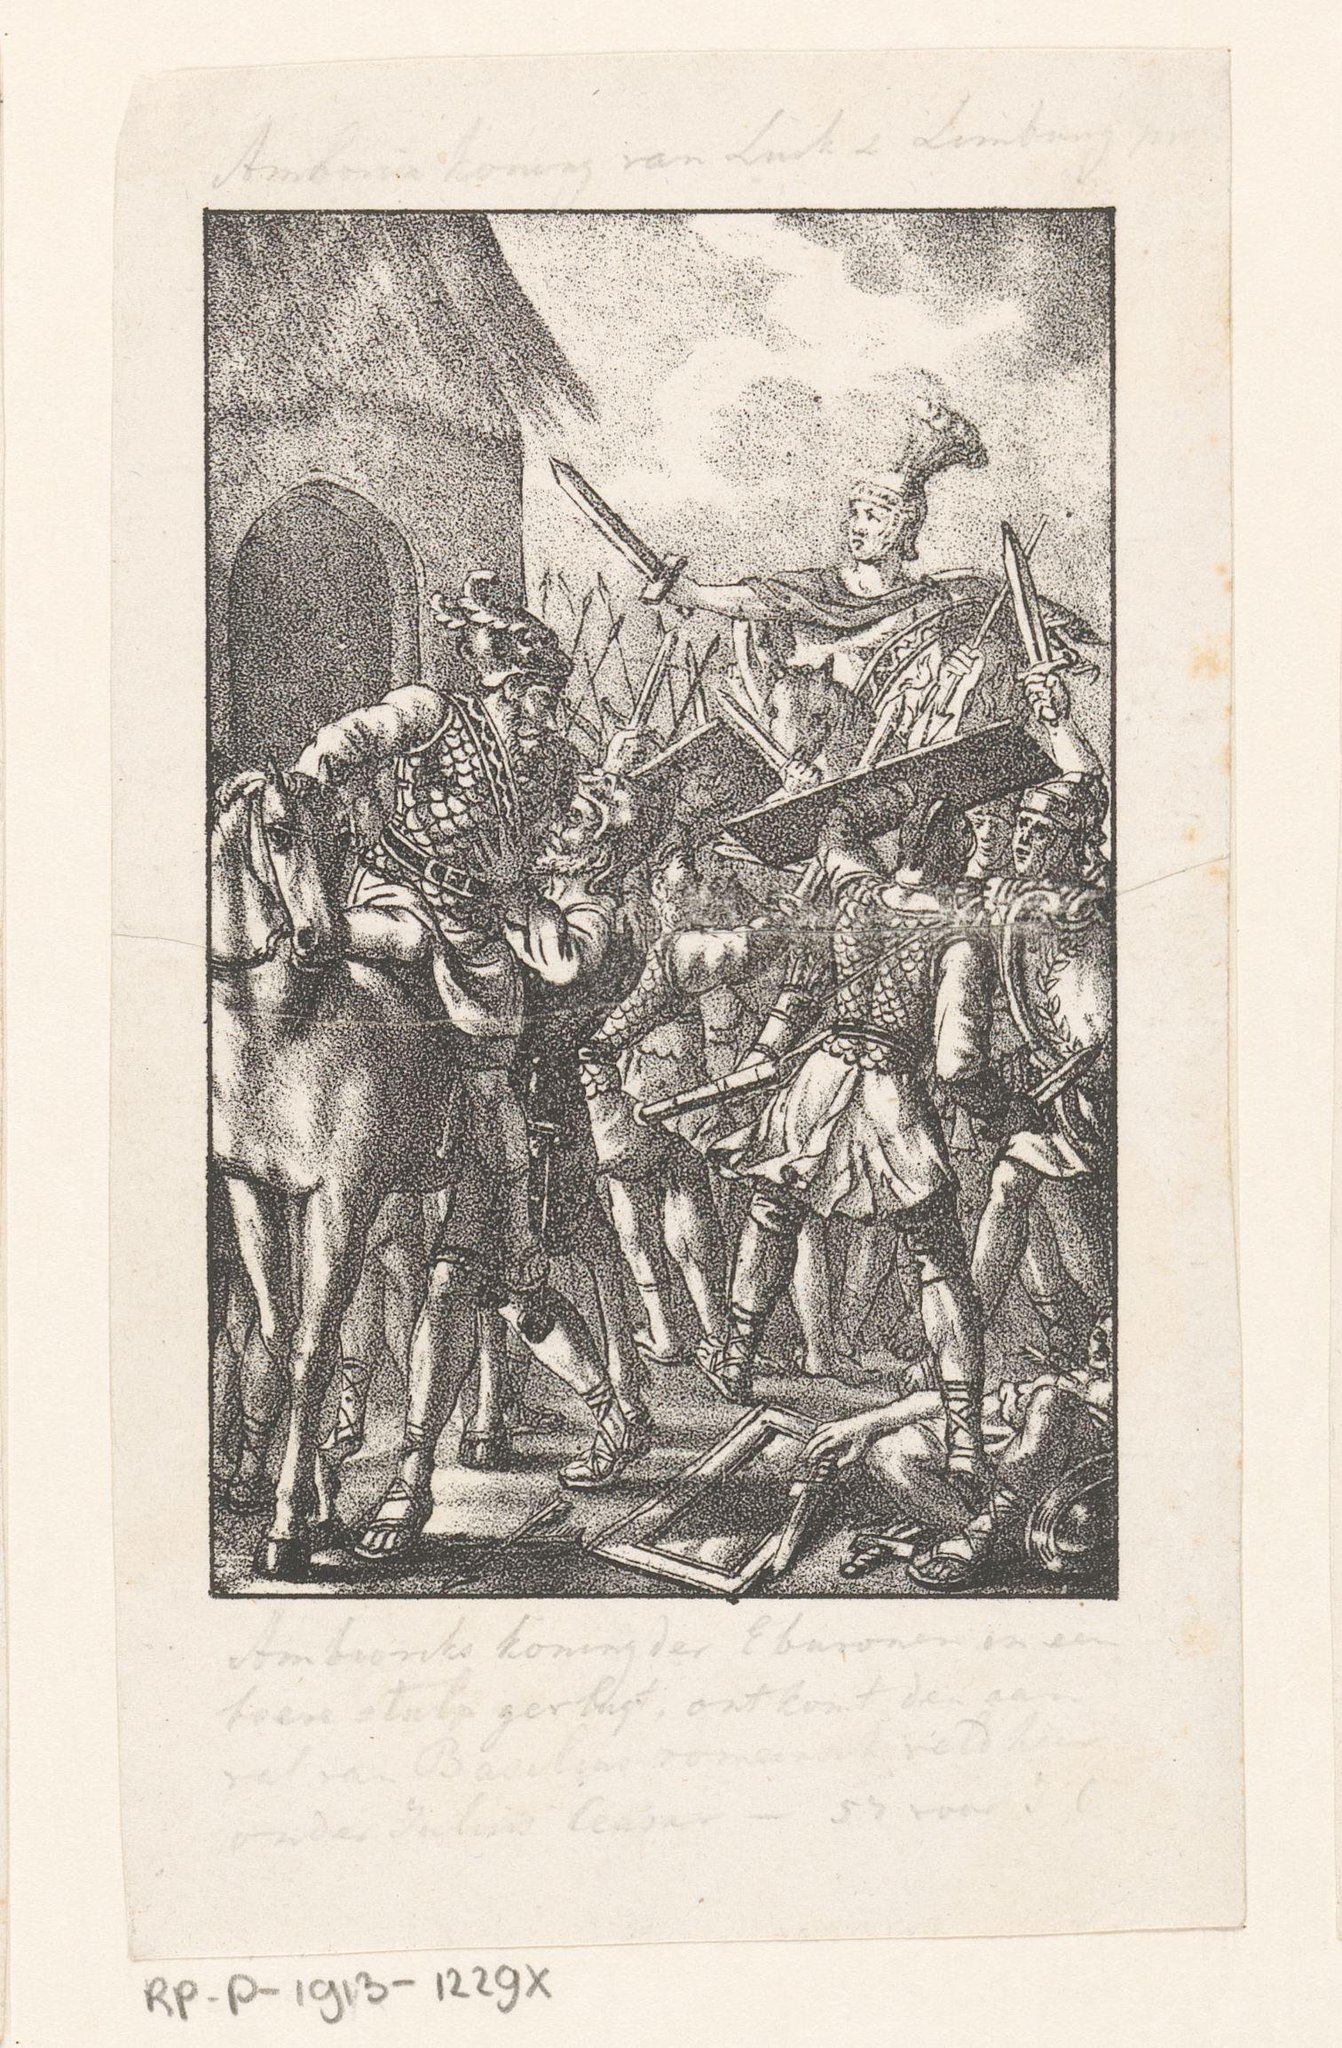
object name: print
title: Serie prenten over historische gebeurtenissen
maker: Anonymous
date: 1809-1899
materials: paper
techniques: lithograph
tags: escape, escape attempts, extinct, 'historical' peoples: gauls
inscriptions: collector's mark: Lugt 2228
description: Ambiorix, koning van de Gallische stam de Eburonen, zit op zijn paard terwijl zijn soldaten de Romeinen tegen houden.